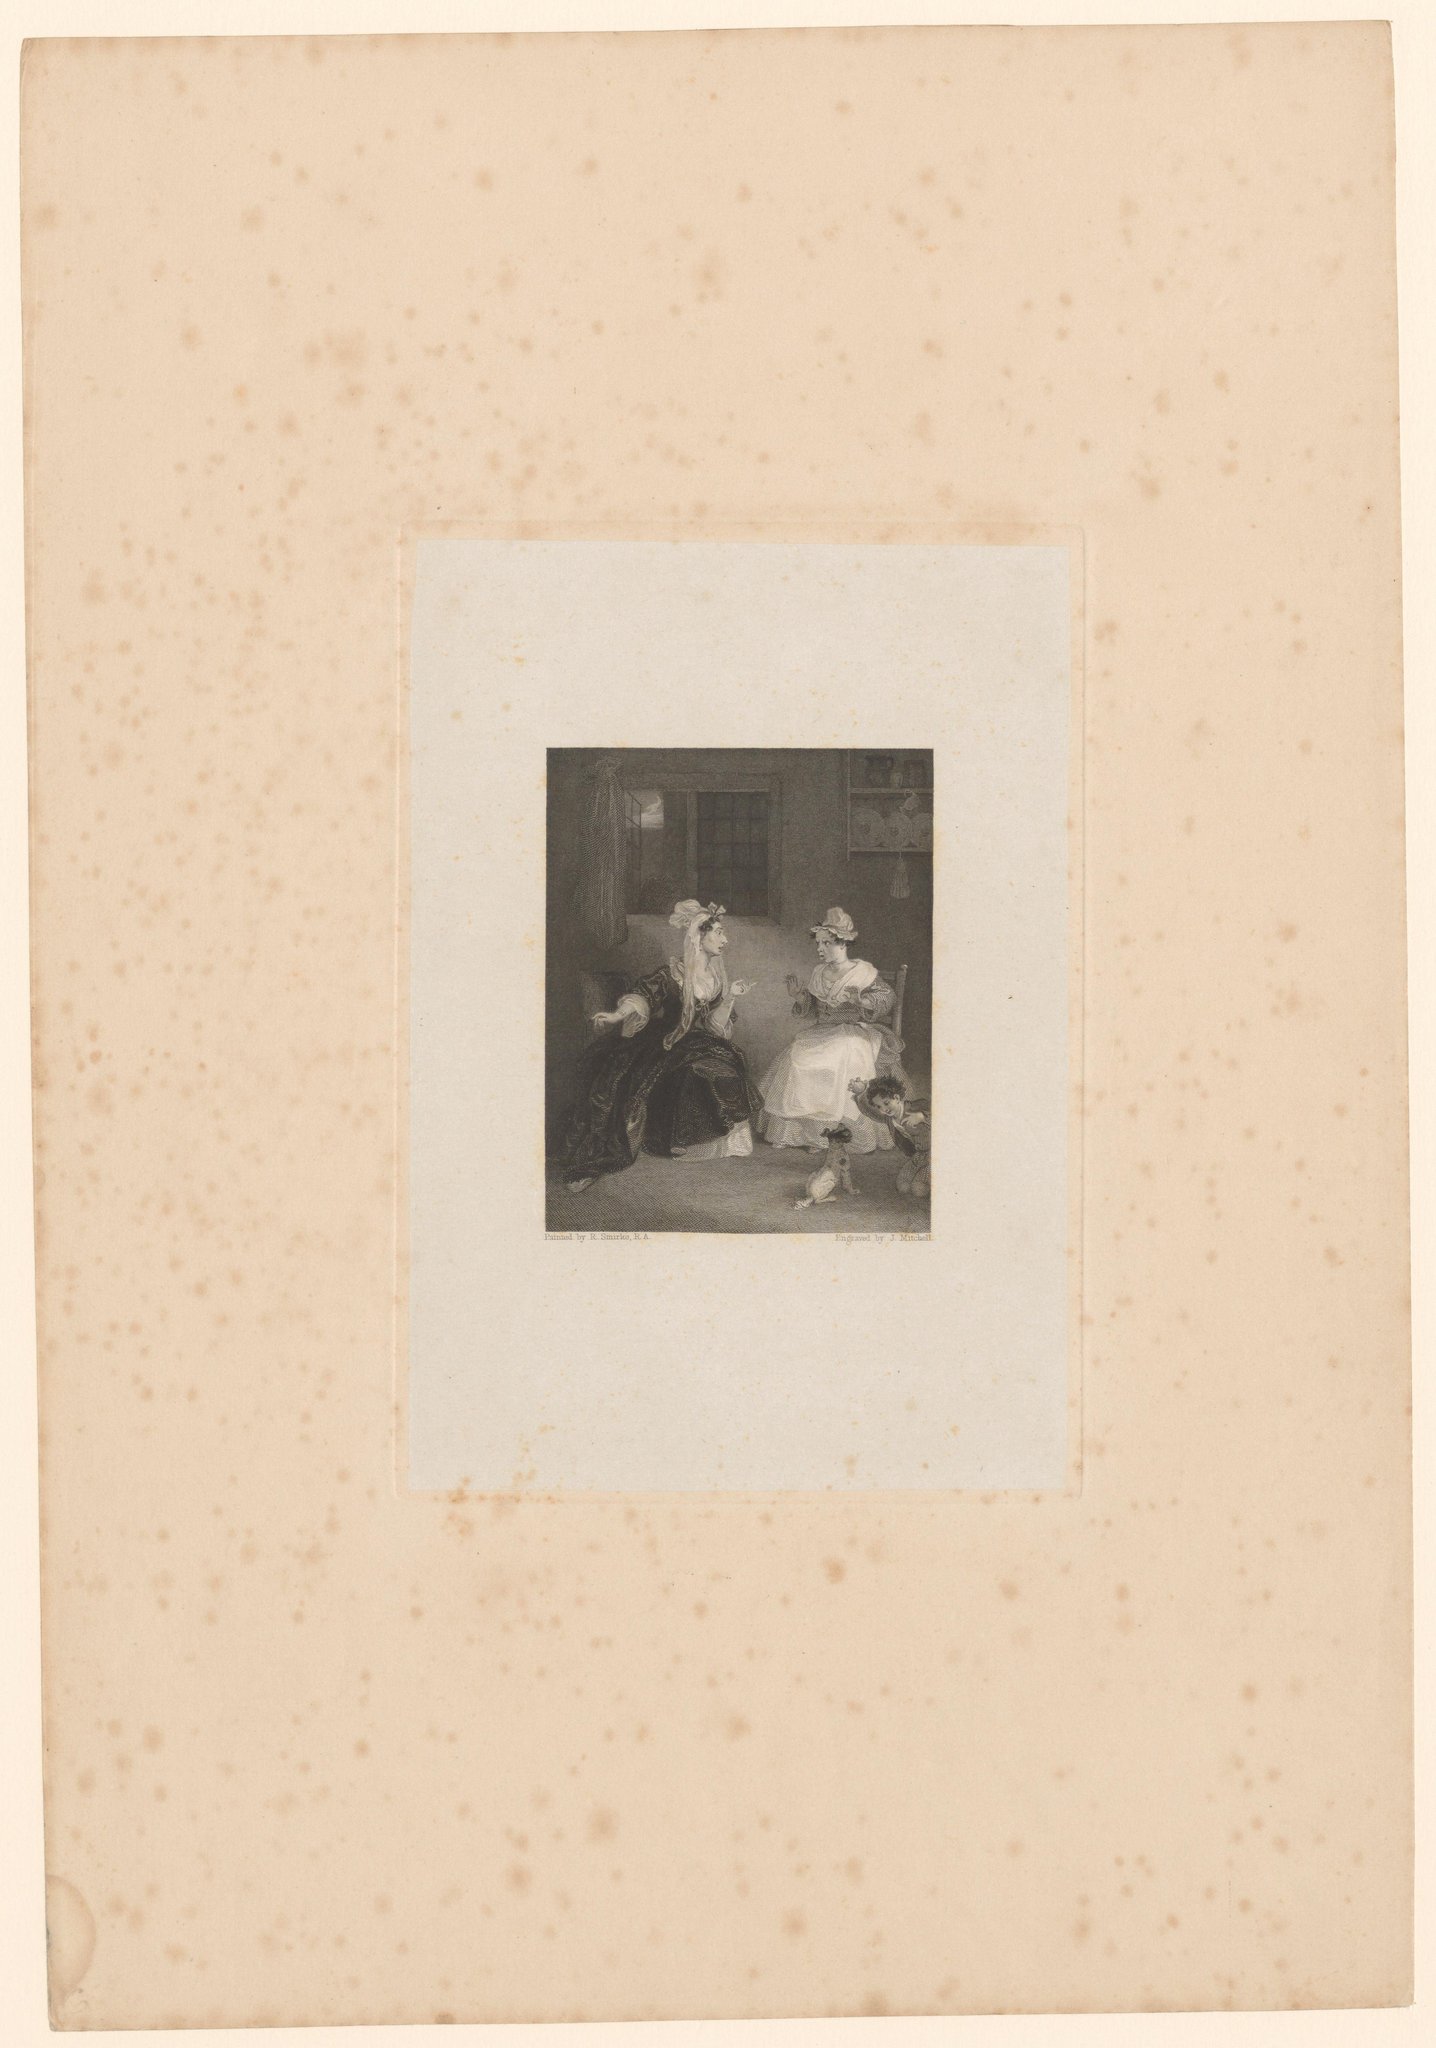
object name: print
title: Twee pratende vrouwen op stoelen en een jongen die met een hond speelt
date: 1832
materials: paper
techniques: etching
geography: england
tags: index finger forwards, pointing, indicating, dog, child between toddler and youth (of undetermined sex)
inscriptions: collector's mark: Lugt 2228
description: Tweede staat met titel 'Scandal' gebruikt in: The Keepsake, 1832.